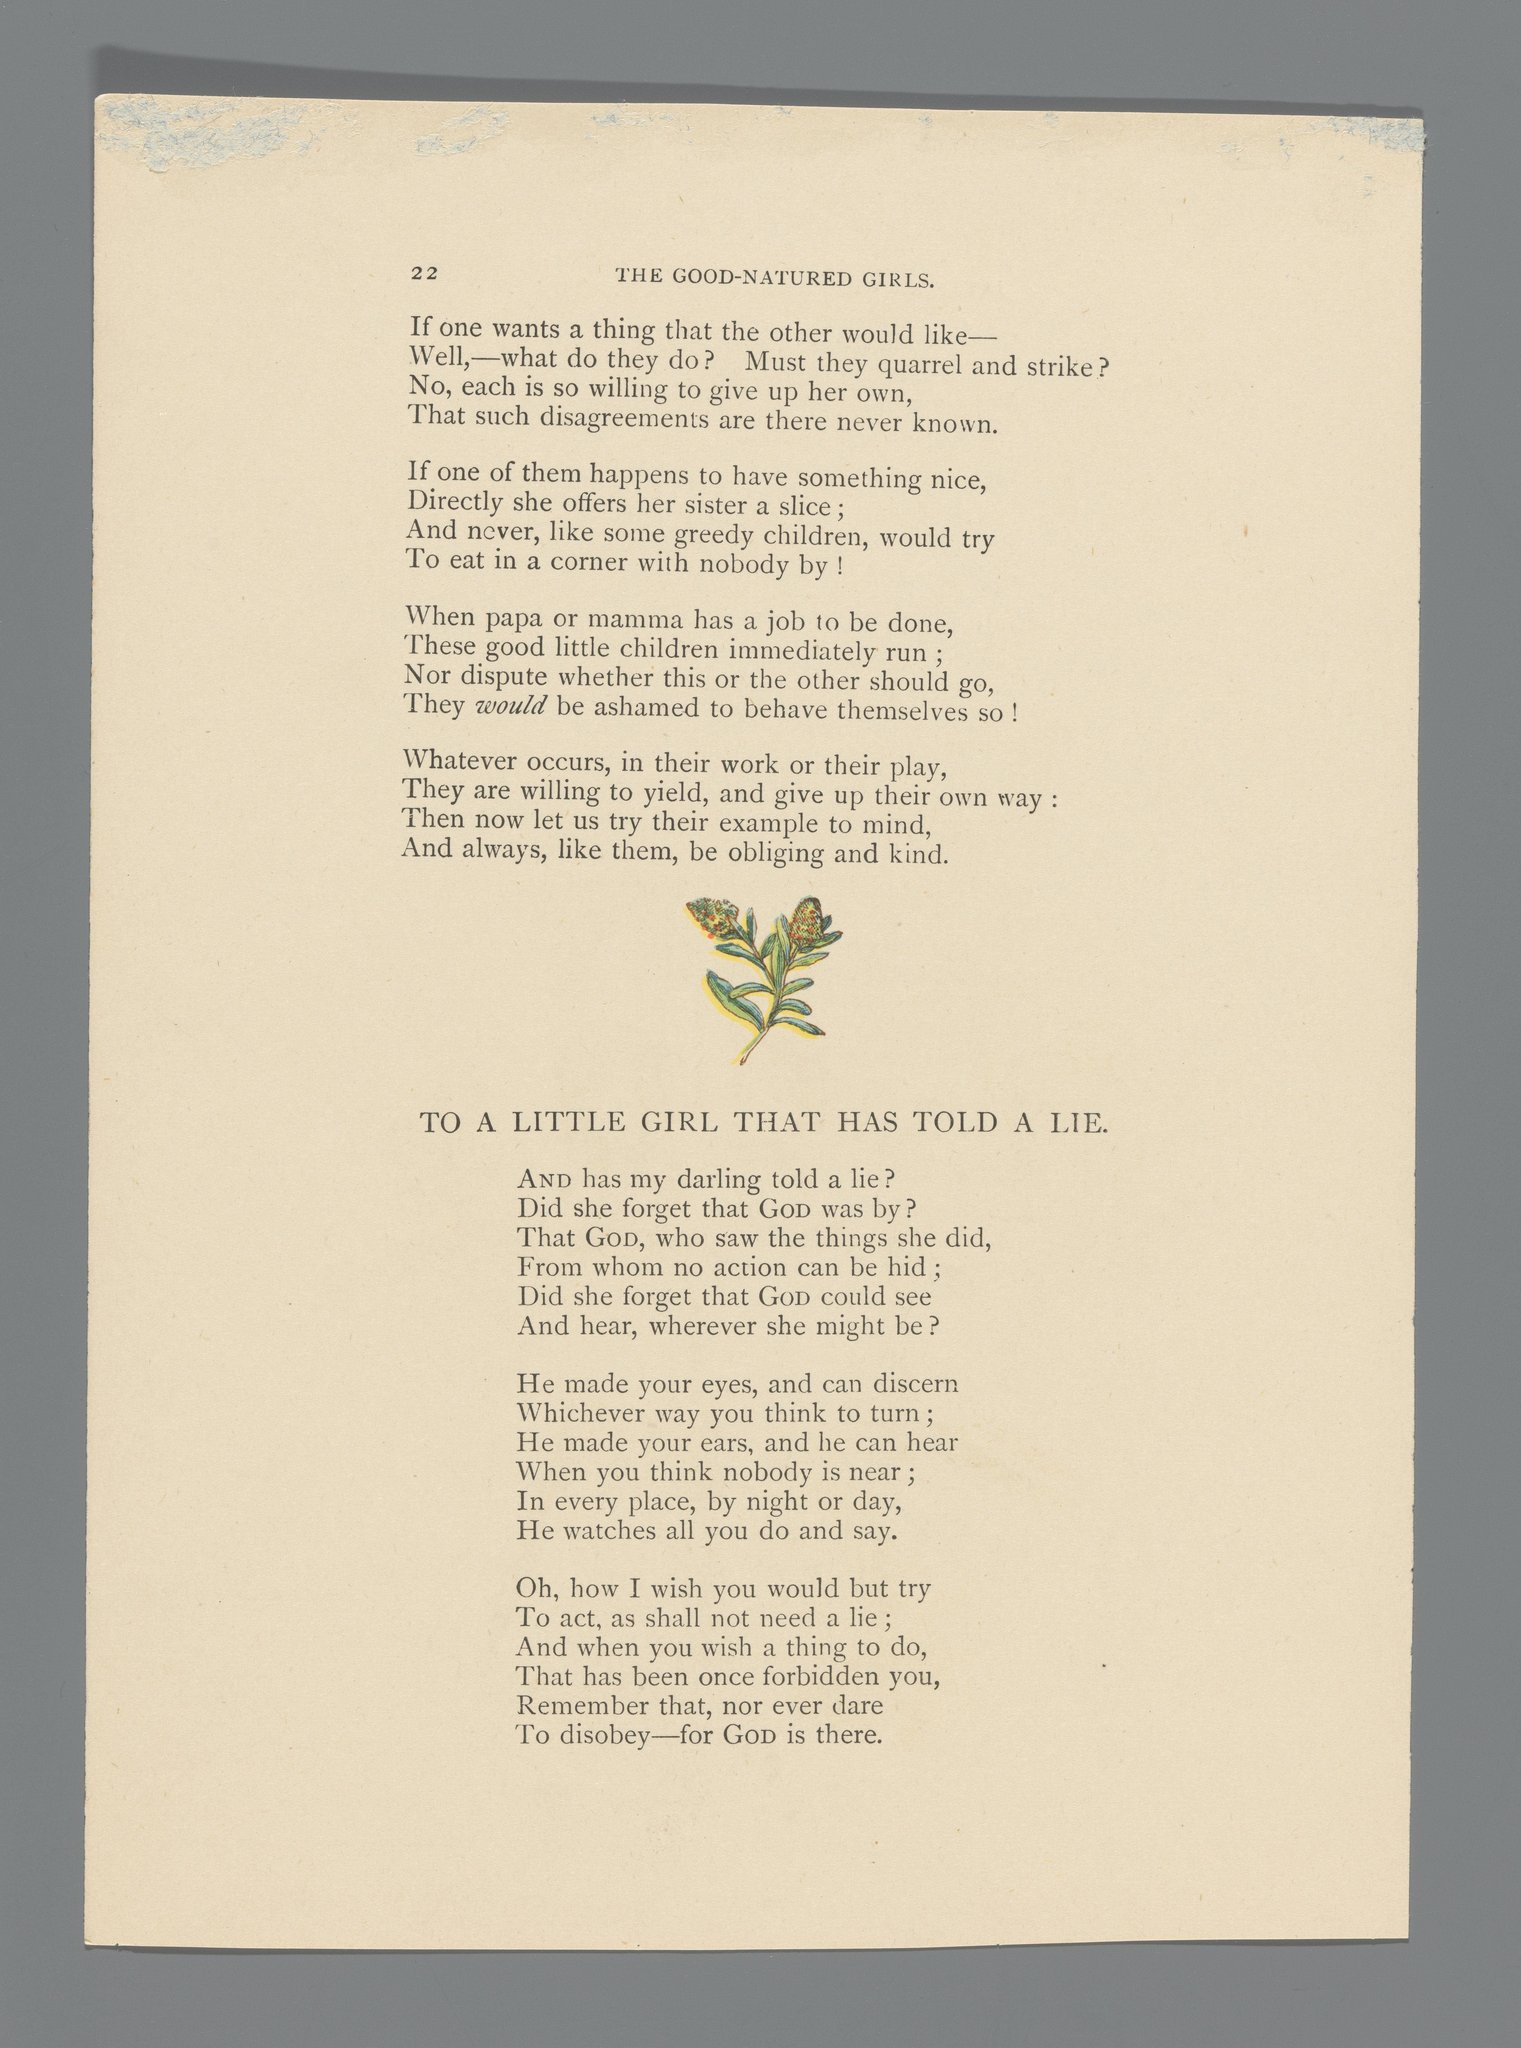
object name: book illustration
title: Plant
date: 1883-1927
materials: paper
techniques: wood engraving, letterpress printing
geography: london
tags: plants; vegetation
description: Prent uit: Jane en Ann Taylor. Little Ann and other poems. Londen: George Routledge & Sons, [1883], p. 22. Of een latere uitgave.